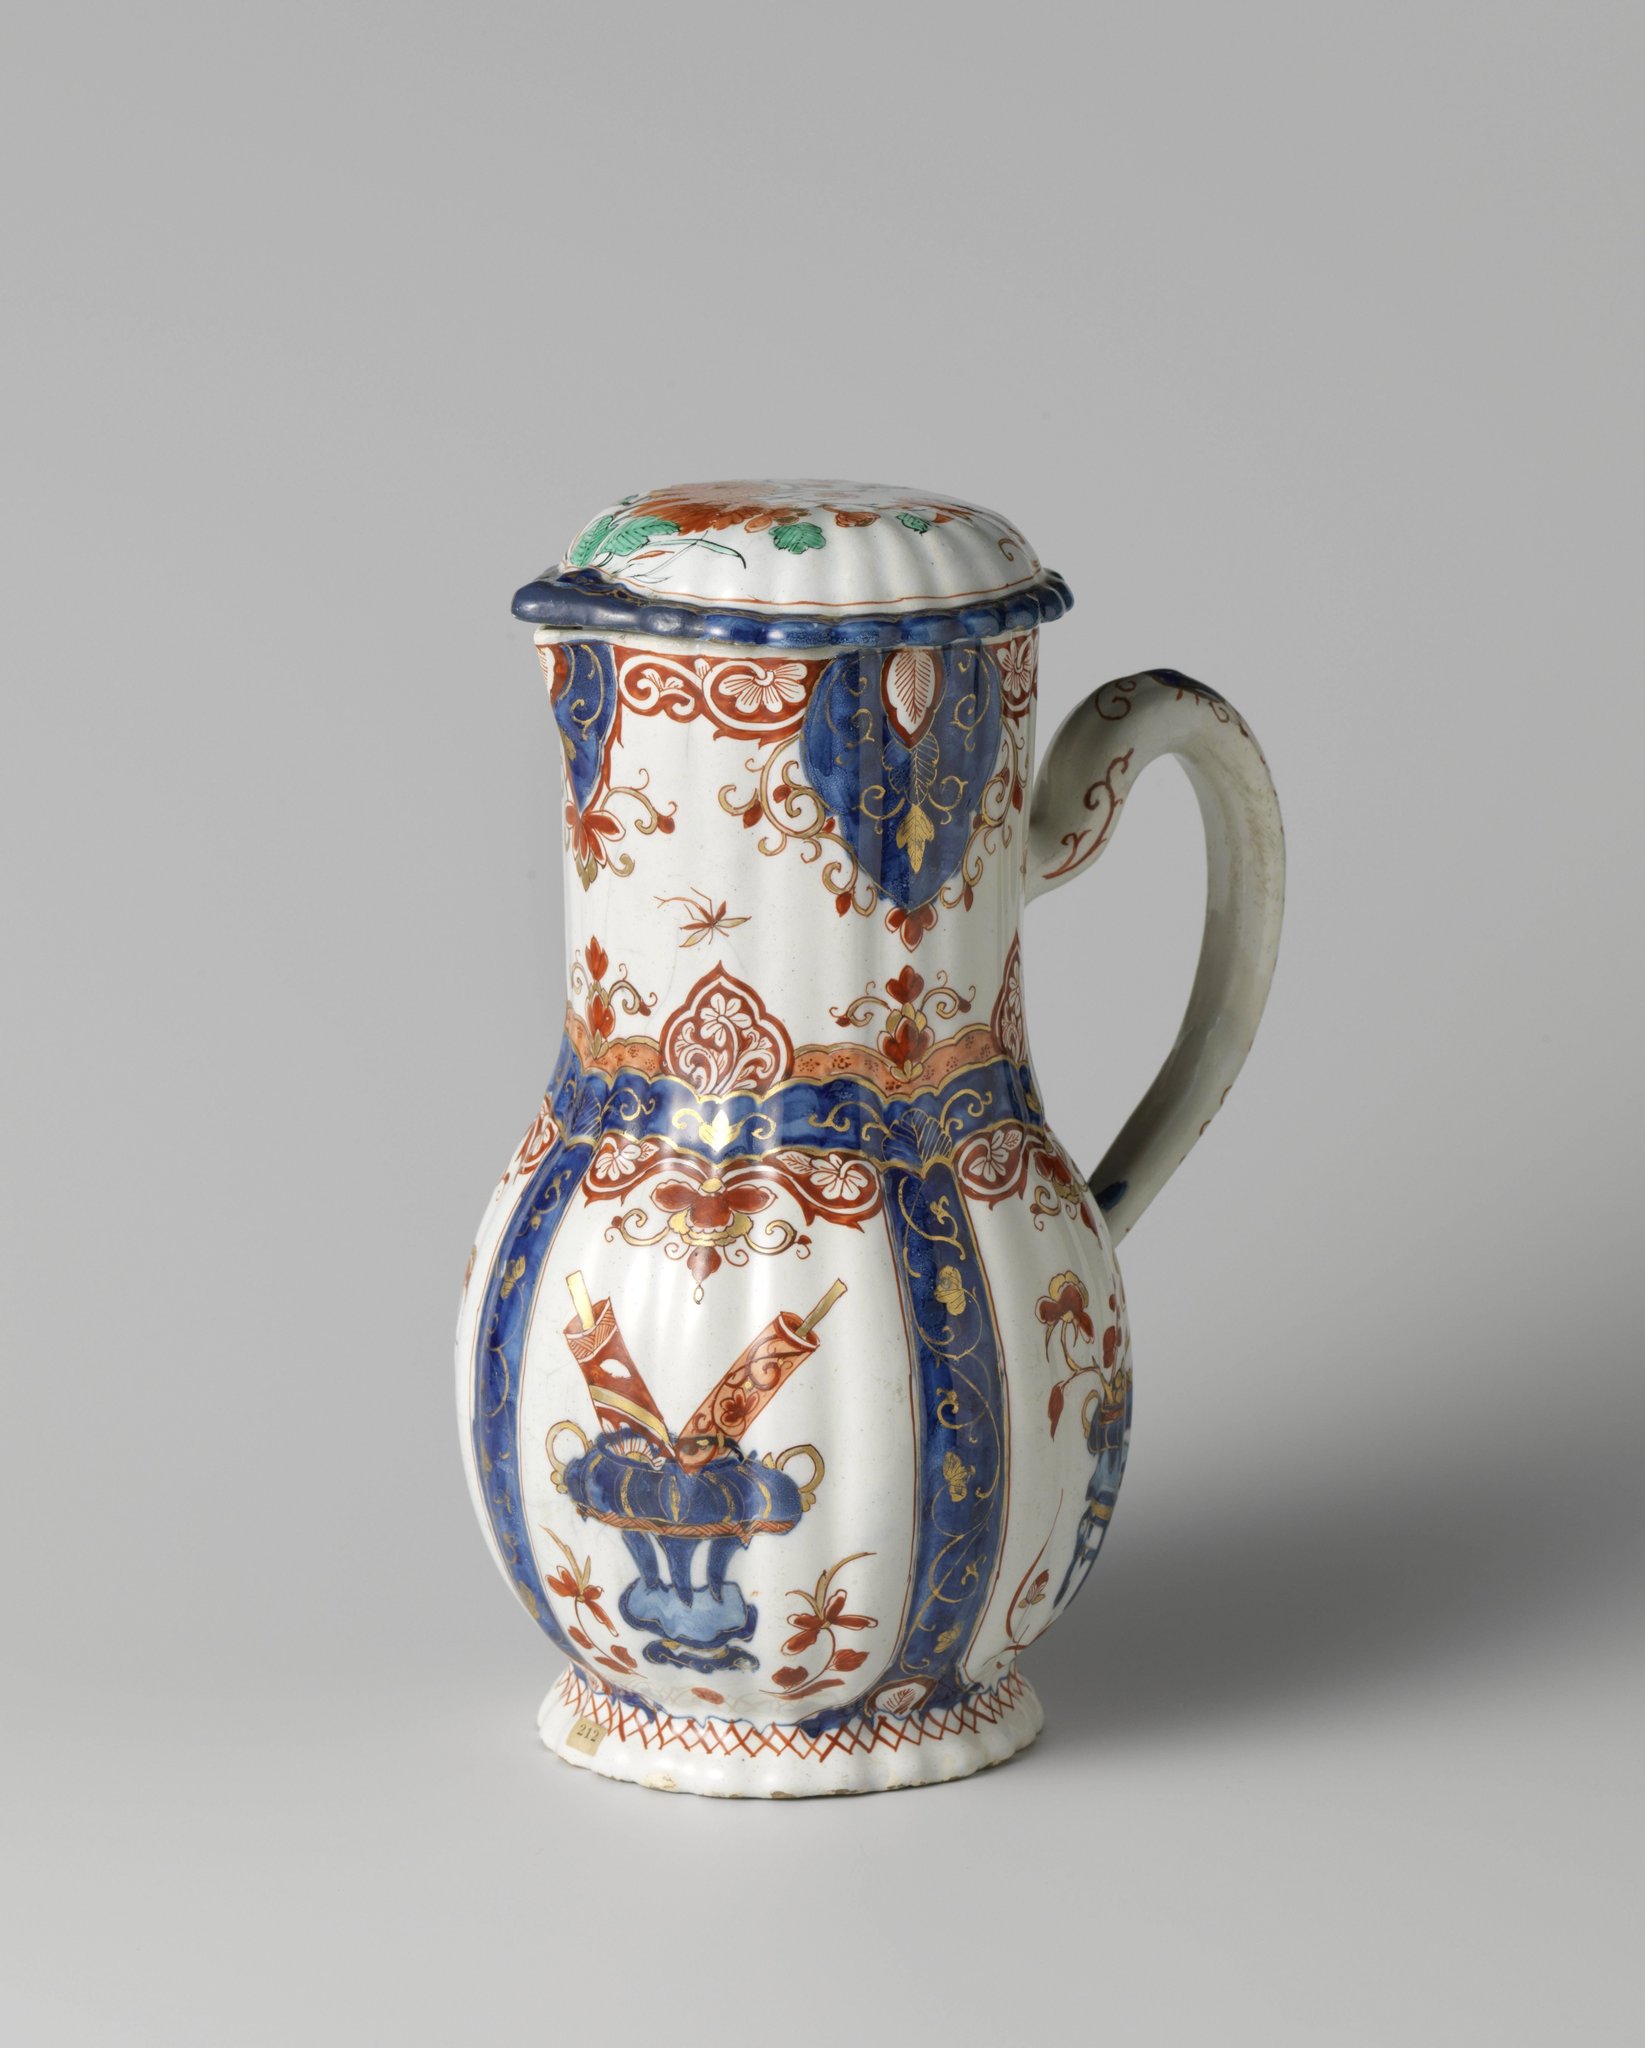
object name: ewer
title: Kan van veelkleurig beschilderd faïence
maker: pieter adriaensz. kocx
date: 1700-1710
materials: earthenware, glaze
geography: delft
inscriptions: collector's mark: ‘collection J.F. Loudon’, mark: ‘APK (ineen)/ no 8’, mark: ‘VIII’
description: deksel en pot horen mogelijk niet bij elkaar